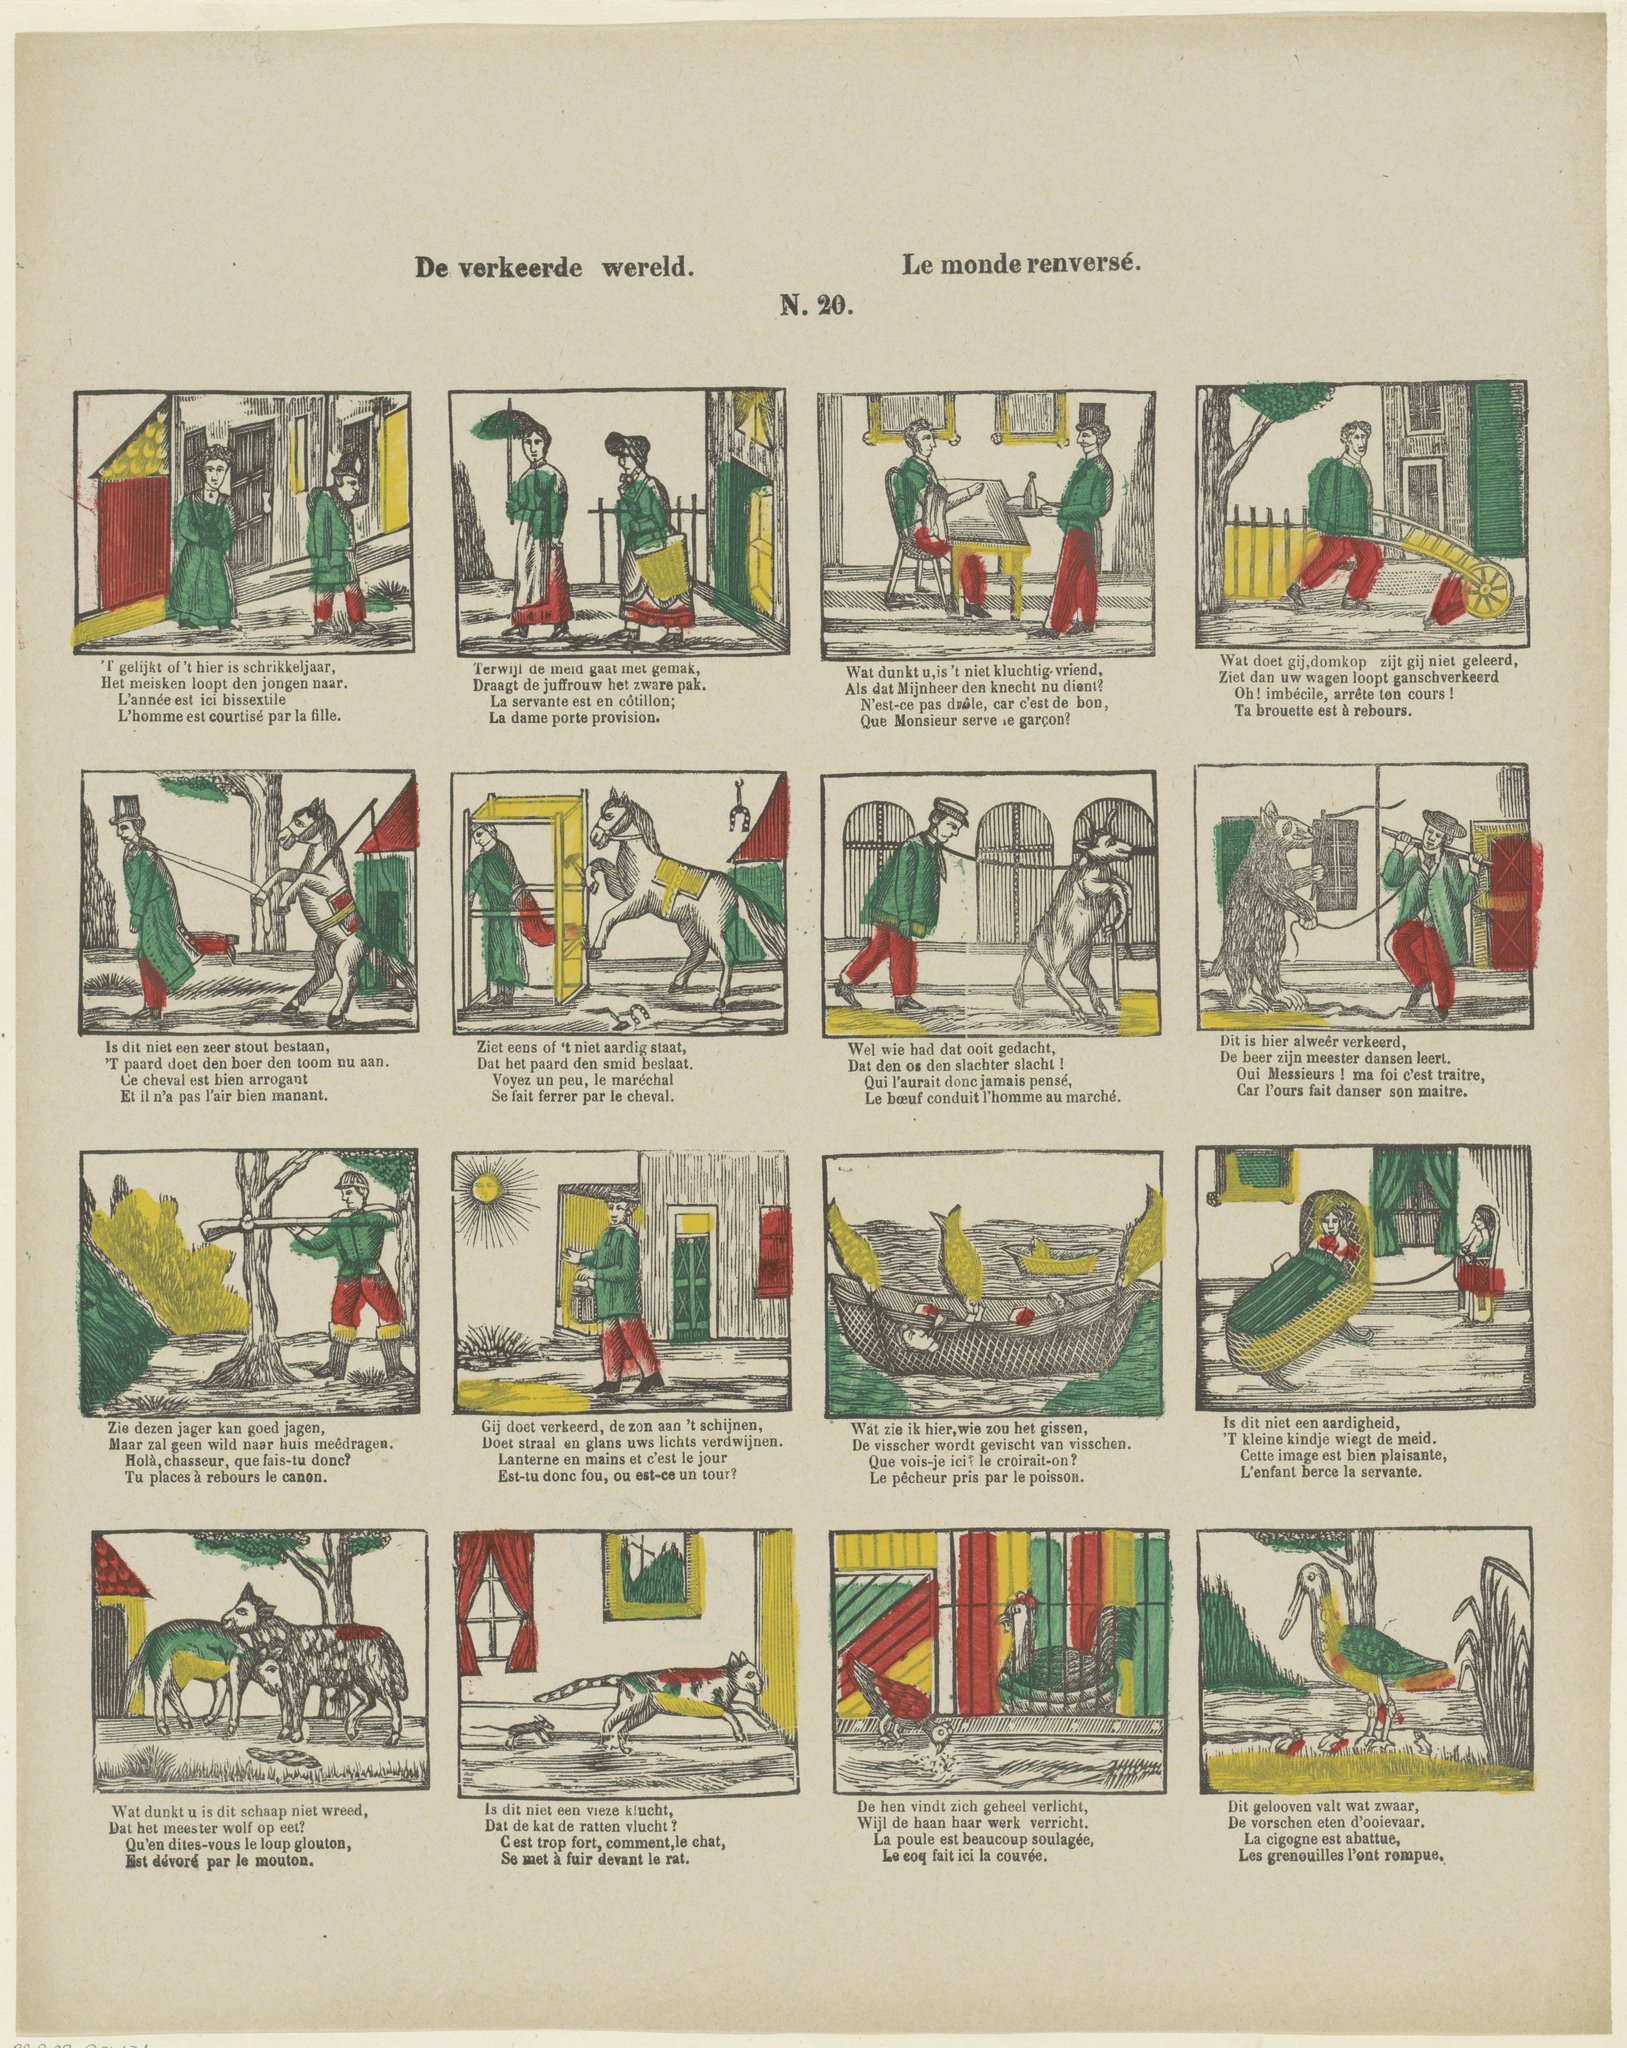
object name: popular print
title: De verkeerde wereld / Le monde renversé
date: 1866-1902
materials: paper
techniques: colour, letterpress printing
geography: europe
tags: 'mundus inversus', the reversed world, the topsy-turvy world, 'le monde bestourné', animals acting as human beings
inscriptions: collector's mark: ‘Edw. Ipers / Oever 27, / Antwerpen.’, collector's mark: Lugt 2760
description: Blad met 16 voorstellingen van de verkeerde wereld, waar onder andere dieren zich als mensen gedragen. Onder elke afbeelding een tweeregelig vers in het Nederlands en in het Frans. Genummerd midden boven: N. 20.